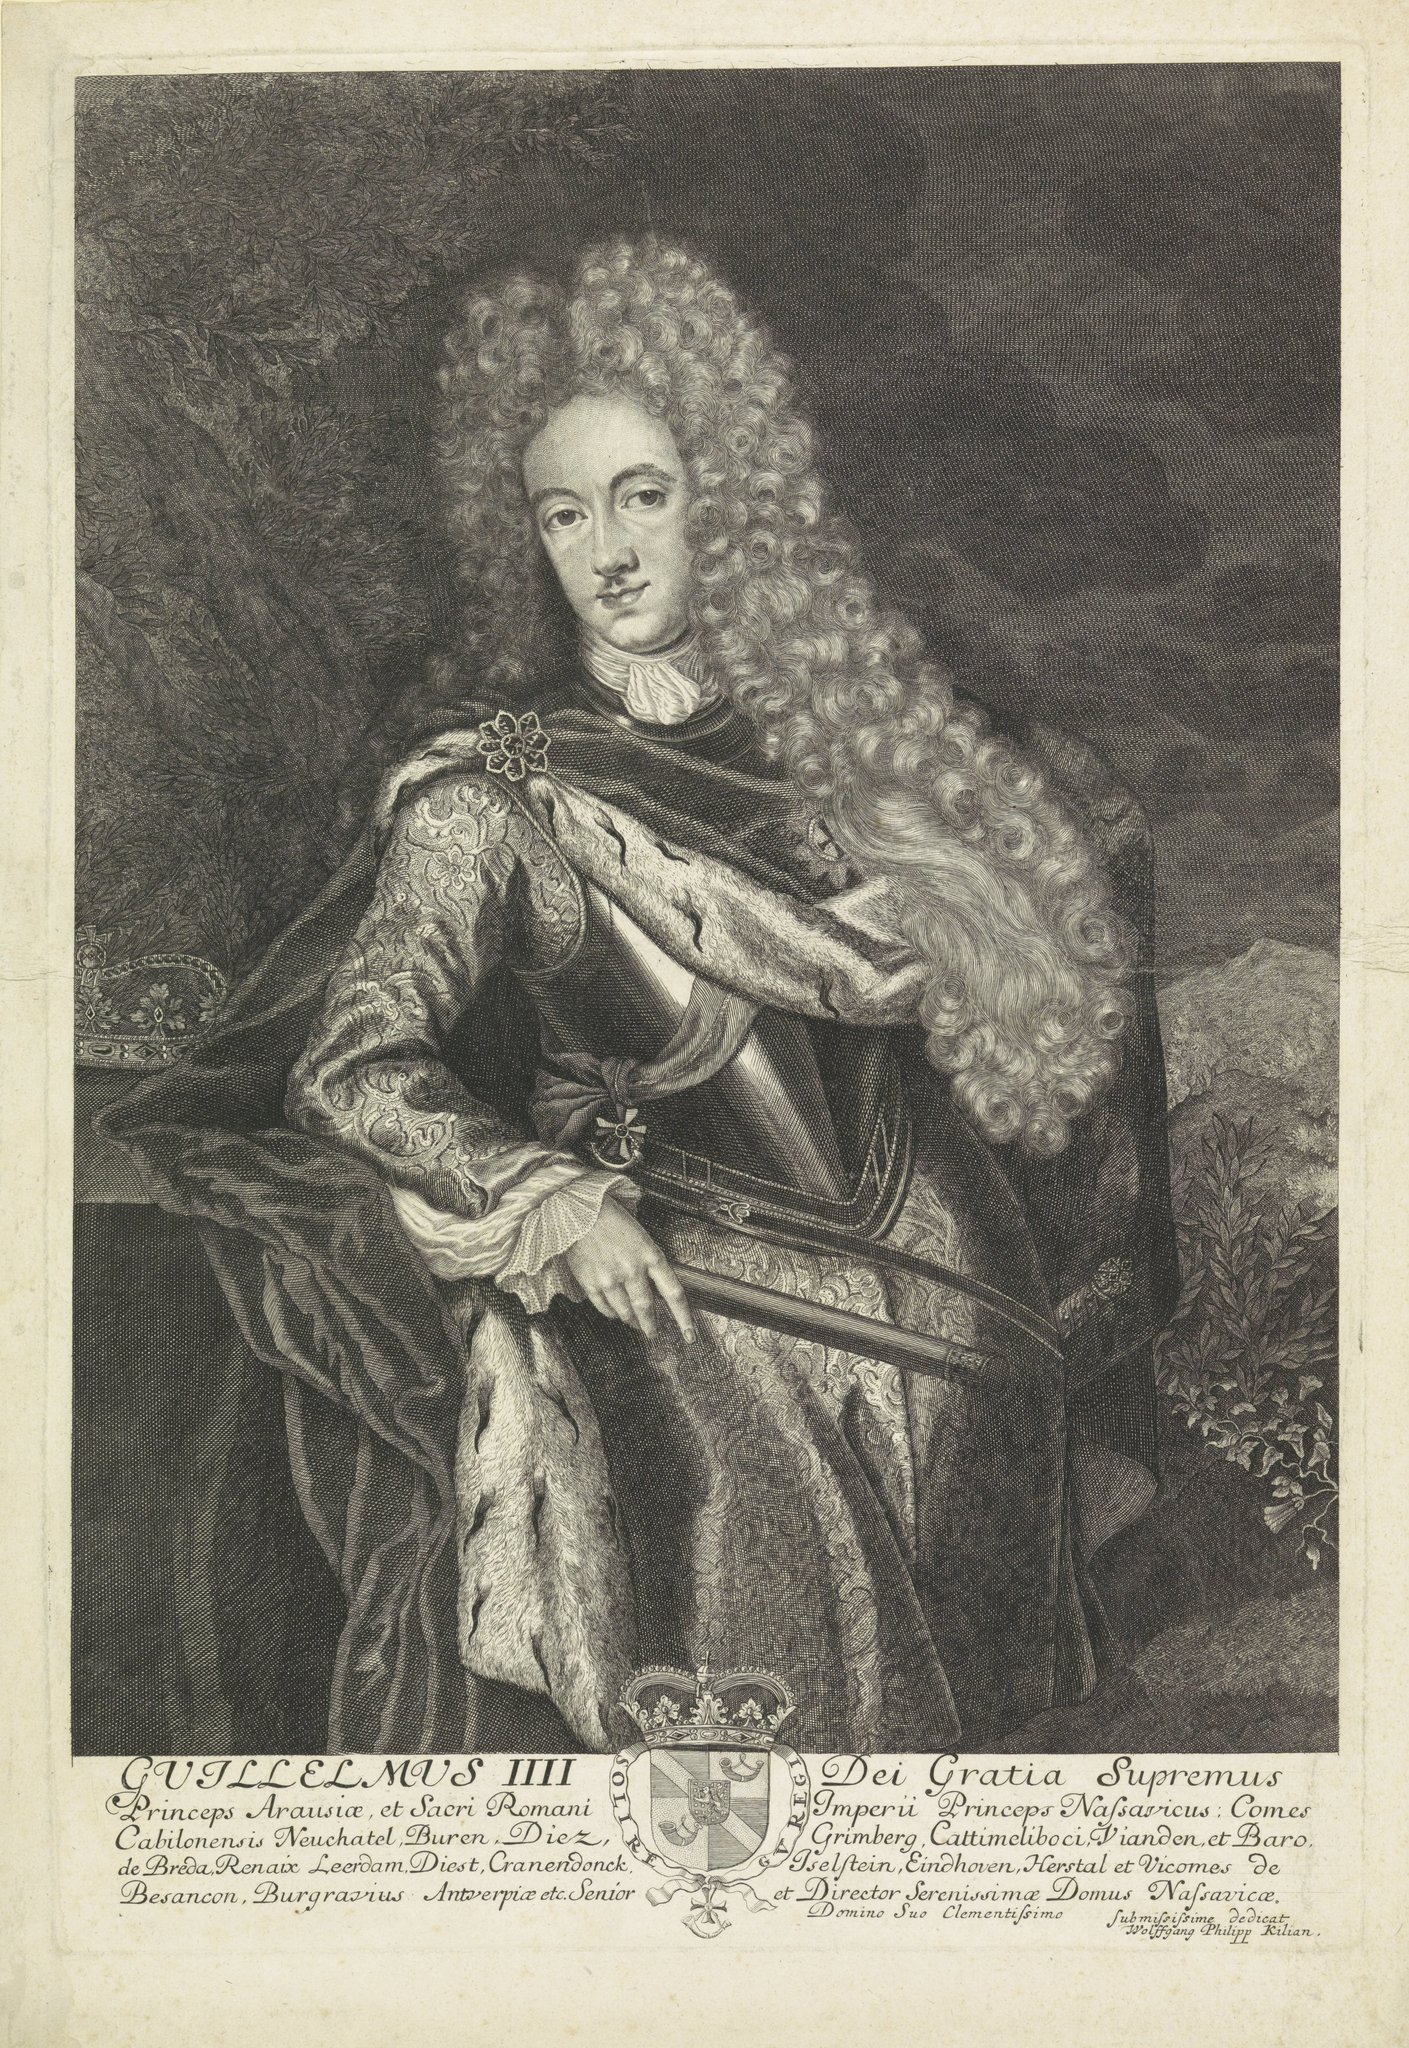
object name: print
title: Portret van Willem IV, prins van Oranje-Nassau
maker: wolfgang philipp kilian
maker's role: artist, draughtsman, print maker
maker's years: 1654-1732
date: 1725-1732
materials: paper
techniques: engraving, etching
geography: germany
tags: the hague, willem iv (prins van oranje-nassau)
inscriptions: collector's mark: Lugt 963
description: De hier vermelde titel verwijst naar de hoogst verkregen titel van de geportretteerde, niet per se naar de titel die de geportretteerde op deze voorstelling draagt.